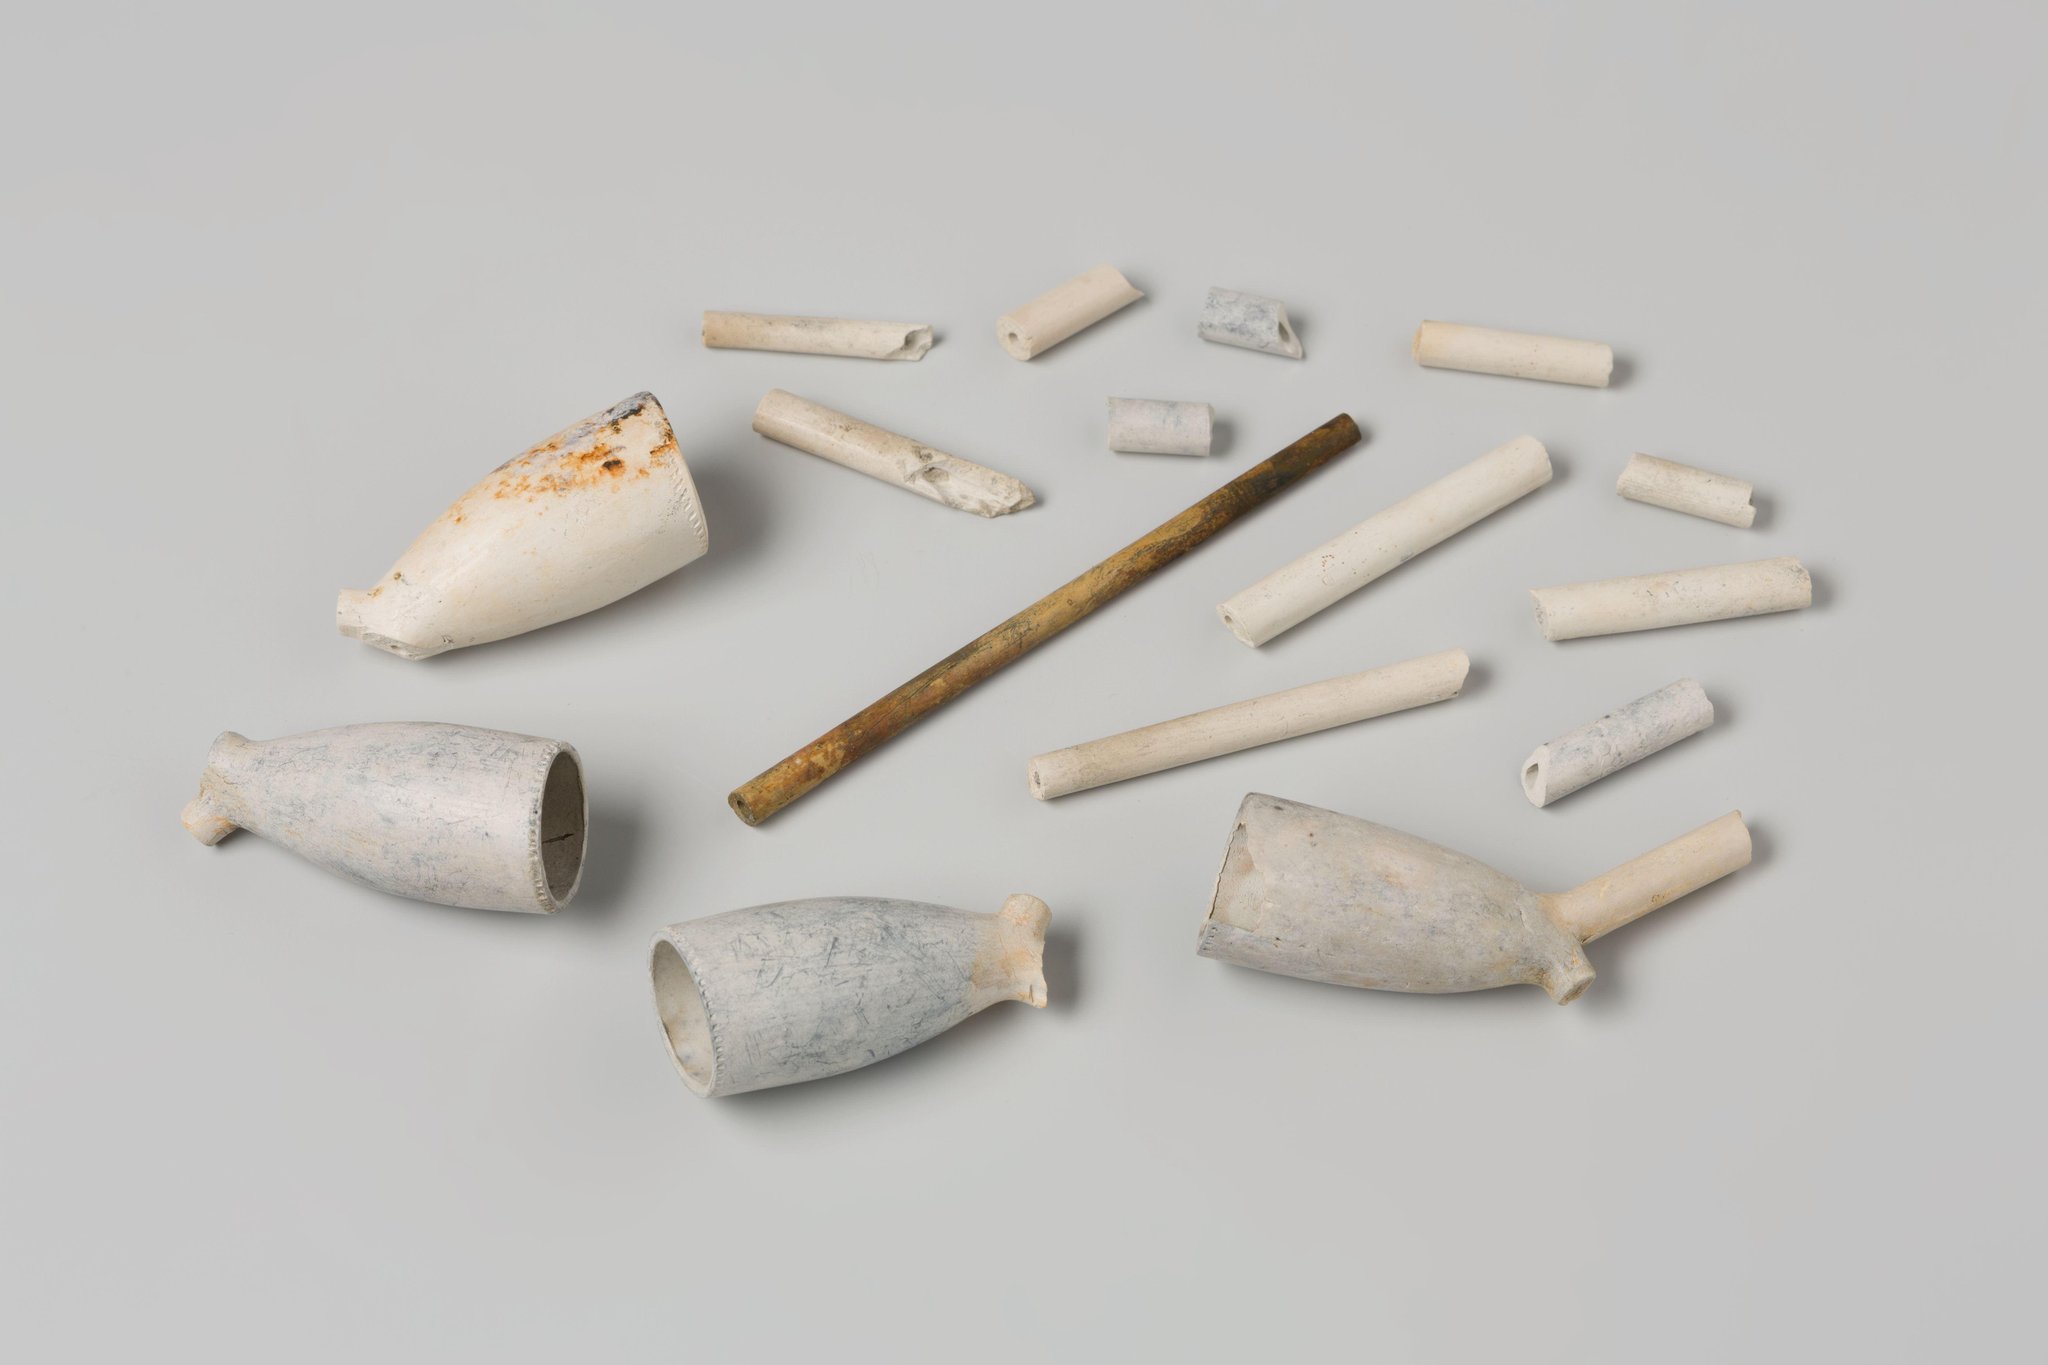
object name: pipe stem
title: Fragmenten van pijpenkoppen en pijpenstelen uit het wrak van de Oost-Indiëvaarder 't Vliegend Hart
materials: clay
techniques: firing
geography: gouda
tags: 't vliegend hart (schip), verenigde oostindische compagnie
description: Vier koppen van aarden Goudse pijpen: drie met hielmerk gekroonde WS (waarvan éen met een stuk steel) die blauwwit van kleur zijn. En één kop met hielmerk gekroonde 67 die gelig is verkleurd. Twaalf stukken steel.